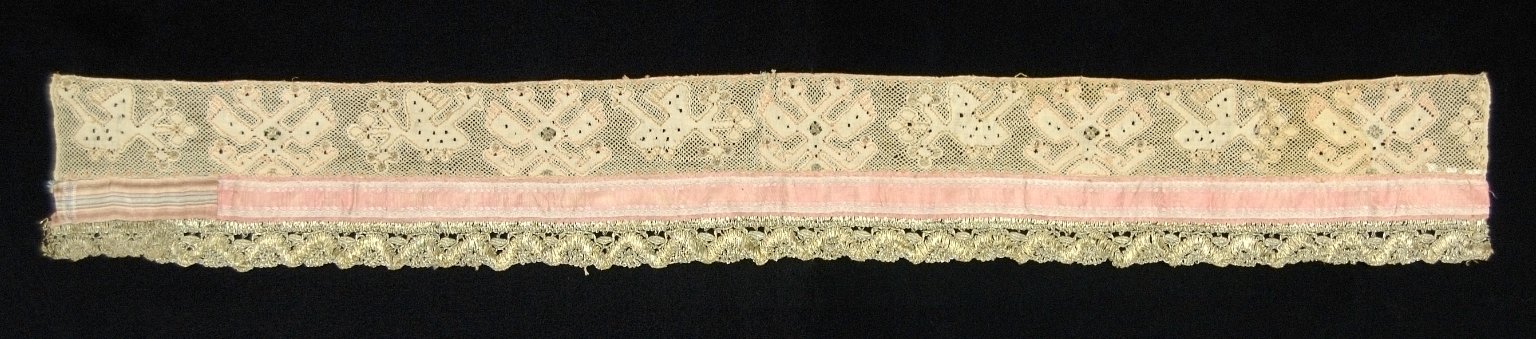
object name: textile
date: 1800-1850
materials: linen, silk